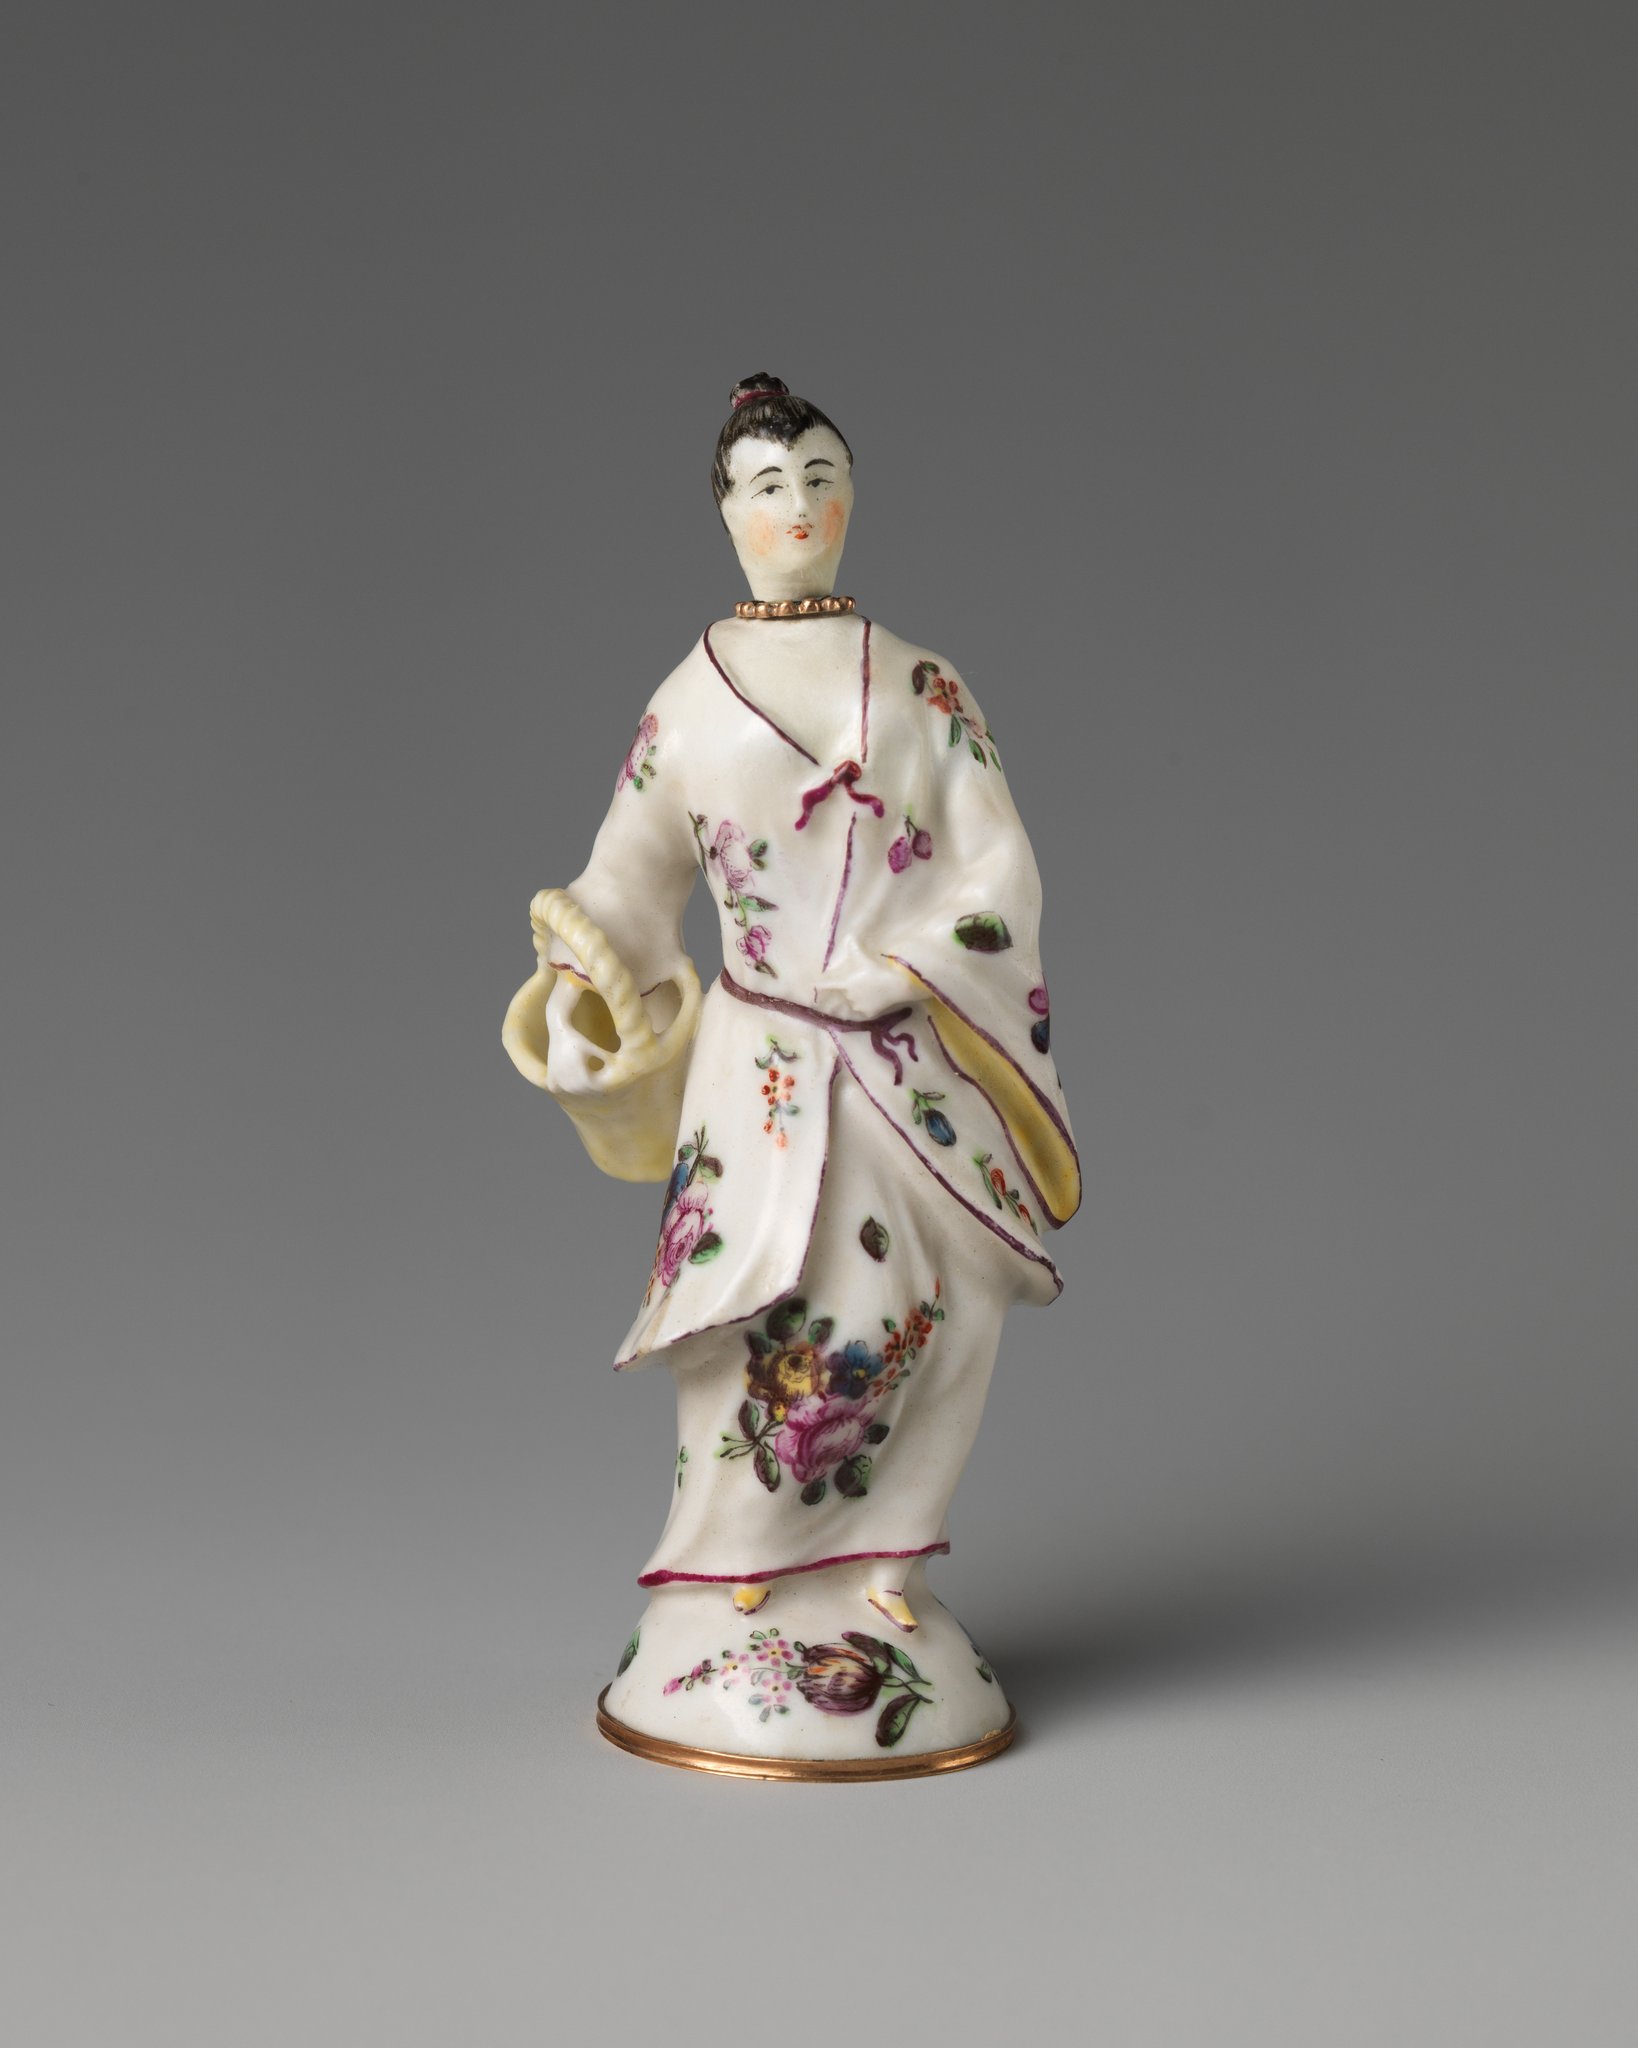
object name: scent bottle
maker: saint james's factory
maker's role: maker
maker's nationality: british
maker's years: 1749-1759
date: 1750-1755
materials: soft paste porcelain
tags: women,flowers